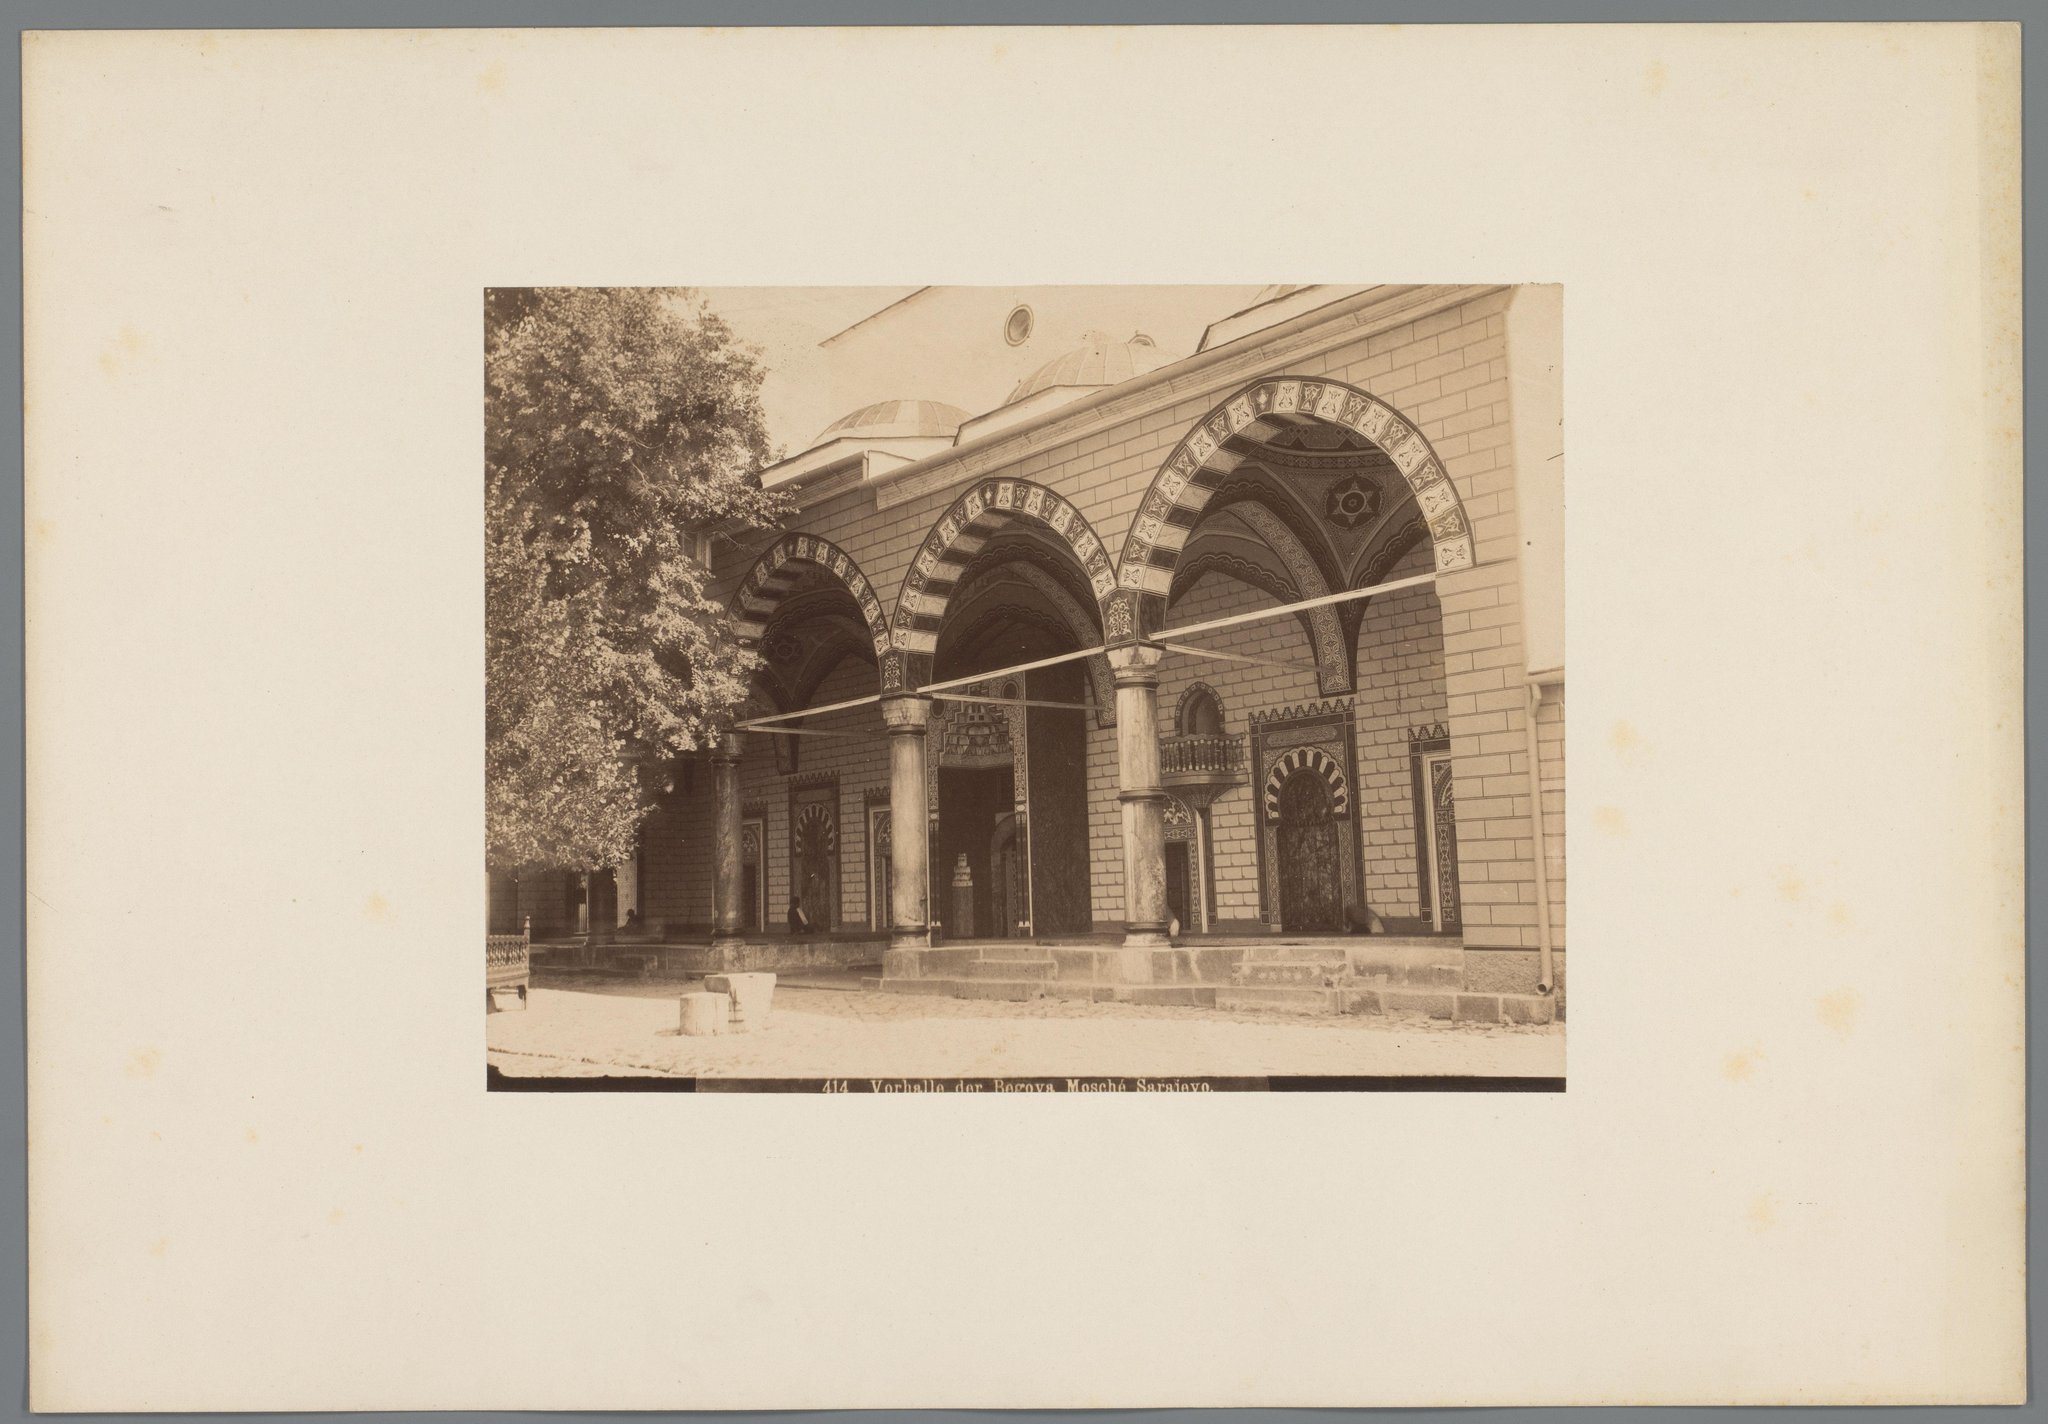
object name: photograph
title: Vorhalle der Bogova Mosché Saraievo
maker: Anonymous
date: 1870-1900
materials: cardboard, paper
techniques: albumen print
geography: sarajevo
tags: temple, shrine ~ islam, mohammedanism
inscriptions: collector's mark: Lugt 2228, number: ‘414’